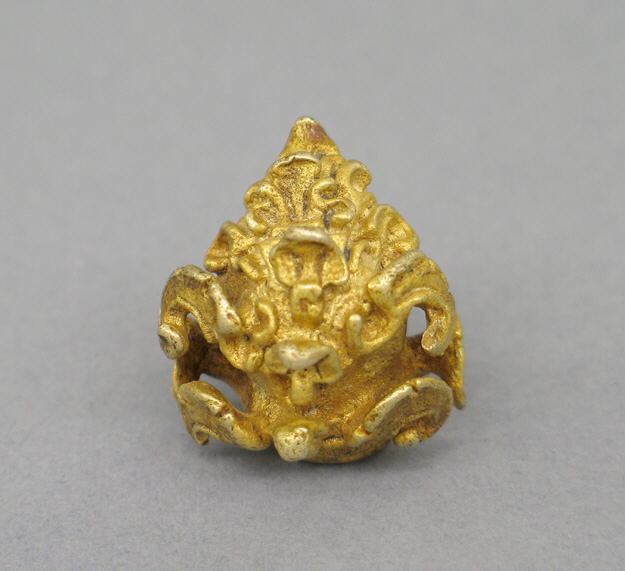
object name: finial clip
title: Rod Finial Clip with Foliate Ornamentation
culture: indonesian, javanese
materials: gold